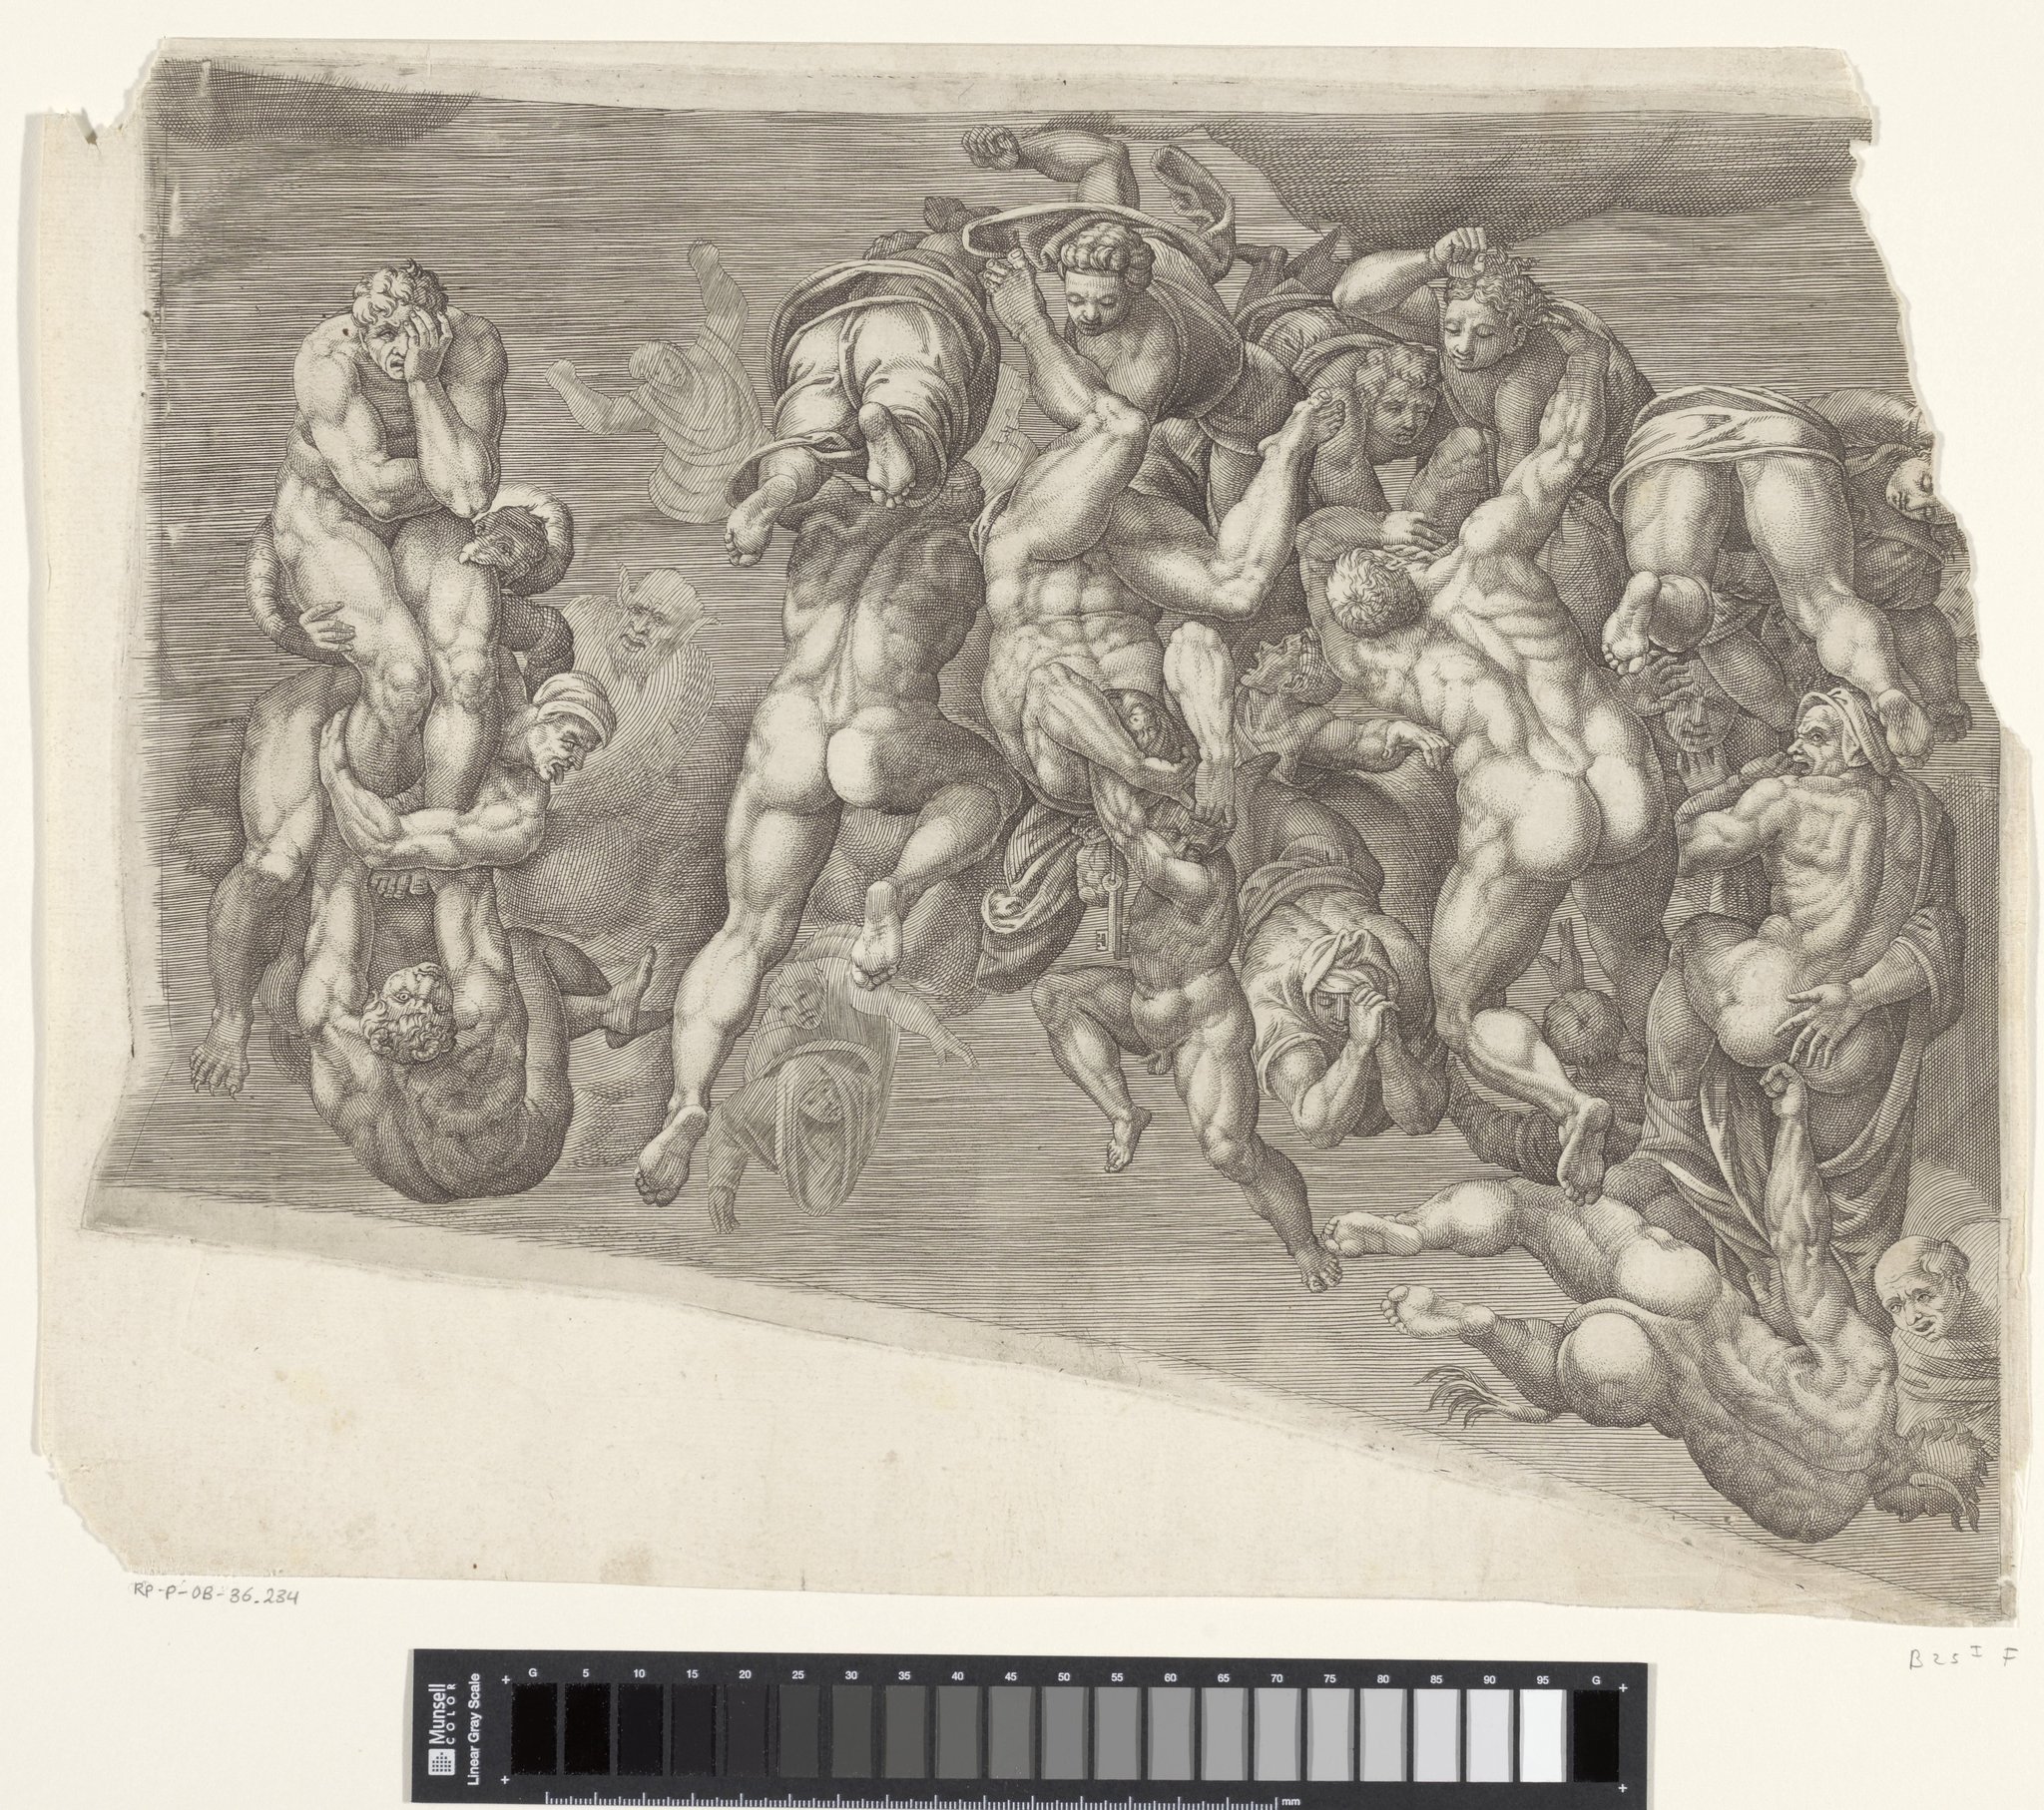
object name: print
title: Het laatste oordeel, blad F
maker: giorgio ghisi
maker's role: print maker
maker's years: 1520-1582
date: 1530-1582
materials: paper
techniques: engraving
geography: vatican city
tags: last judgement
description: Prent maakt deel uit van een groep van tien prenten die samen één grote voorstelling vormen naar het fresco met het Laatste Oordeel door Michelangelo in de Sixtijnse Kapel in het Vaticaan.